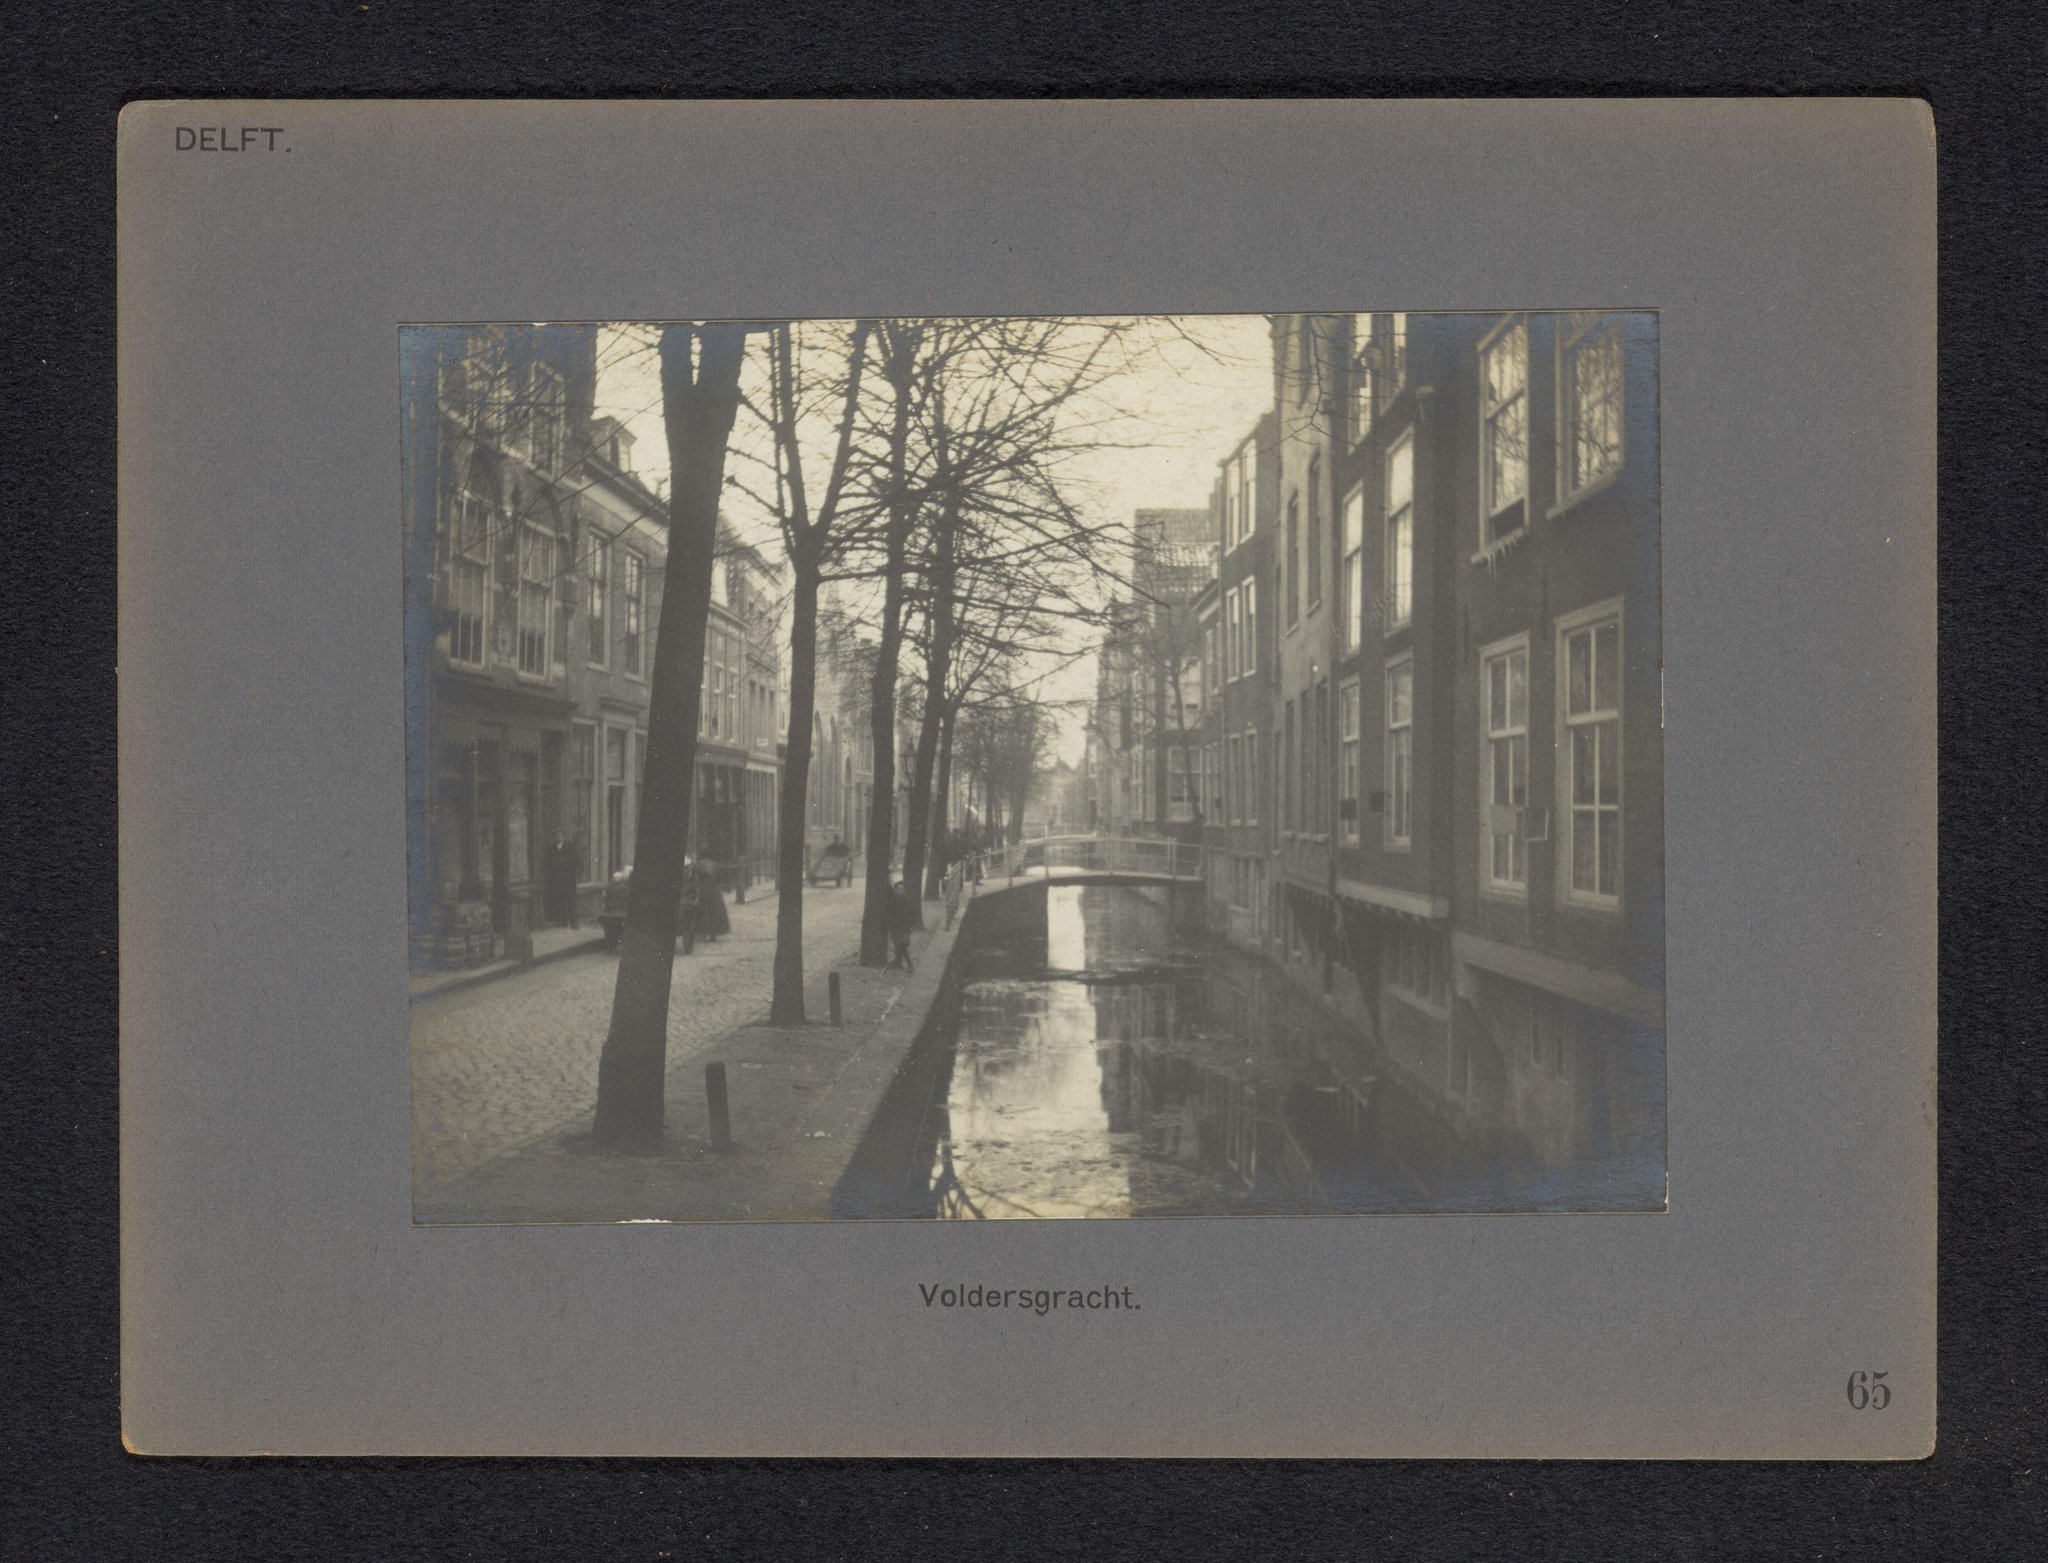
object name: photograph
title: Oude Delft W.Z. No. 141. Lodwijk XV deur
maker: Anonymous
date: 1900-1904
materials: cardboard, photographic support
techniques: gelatin silver print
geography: delft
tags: canals, waters (in city), bridge in city across river, canal, etc.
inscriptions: inscription: ‘Delft.’, number: ‘65’, inscription: ‘Het recht van reproductie dezer photo's wordt door den Uitgever voorbehouden.’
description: Naast de voordeur is te lezen: Maison H.W.J. Bontekoe Cuisine.